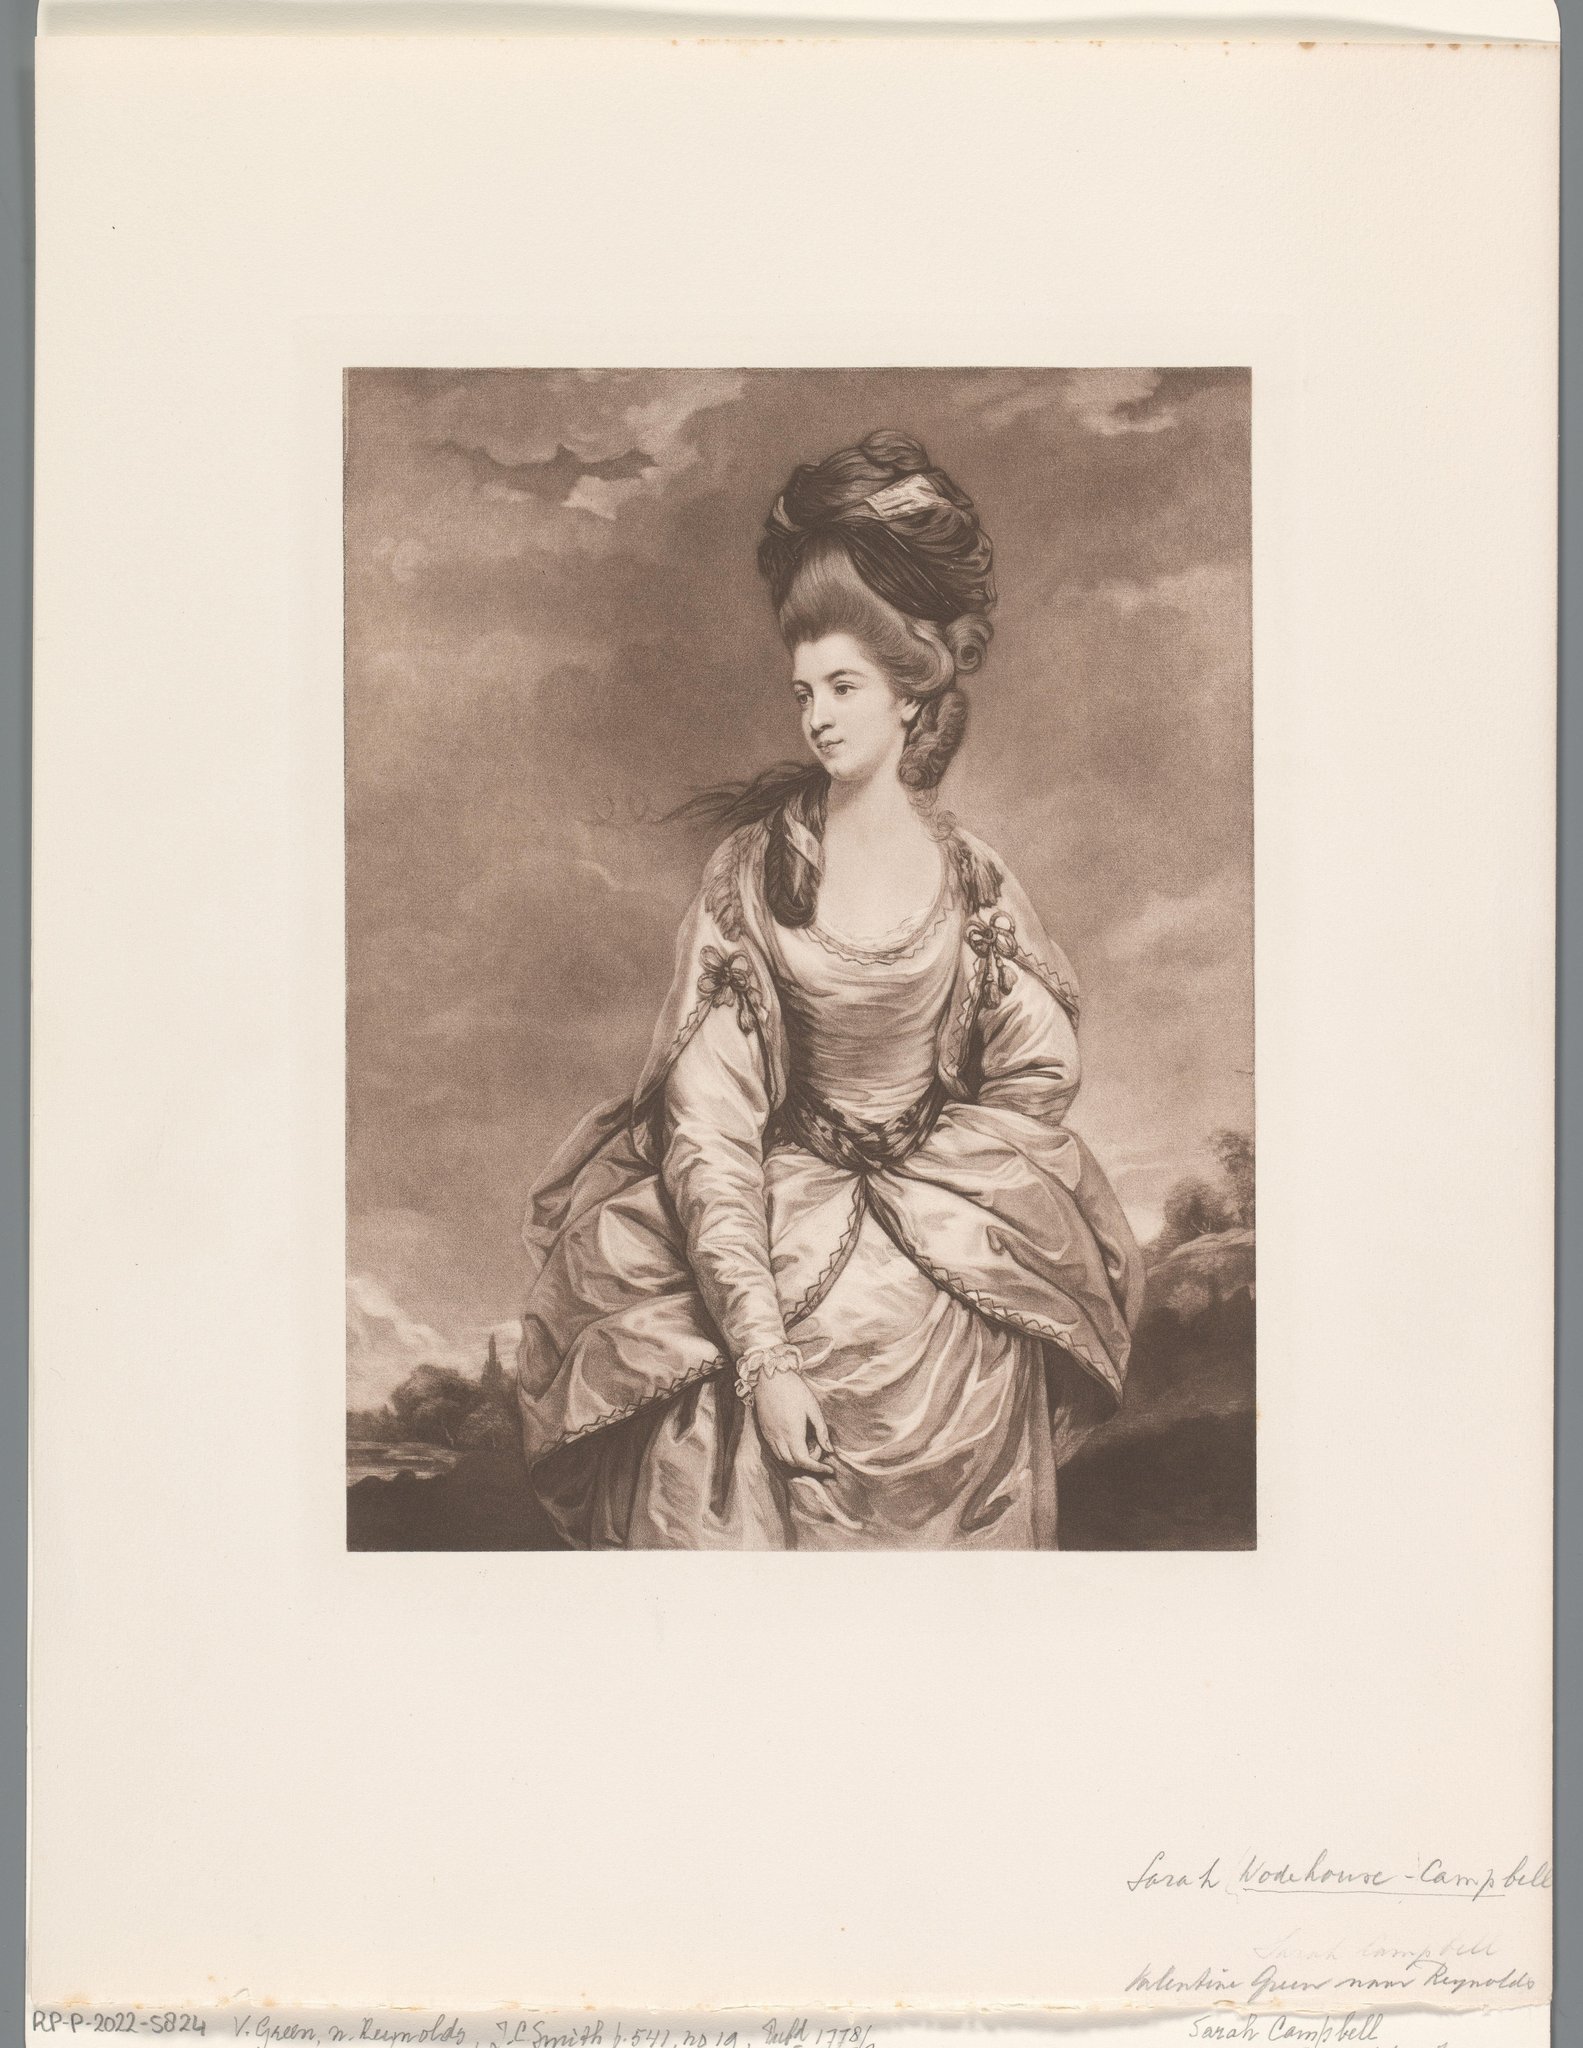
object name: photomechanical print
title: Portret van Sarah Wodehouse-Campbell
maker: Anonymous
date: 1870-1915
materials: paper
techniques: photoaquatint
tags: historical persons - bb - woman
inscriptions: collector's mark: Lugt 2228